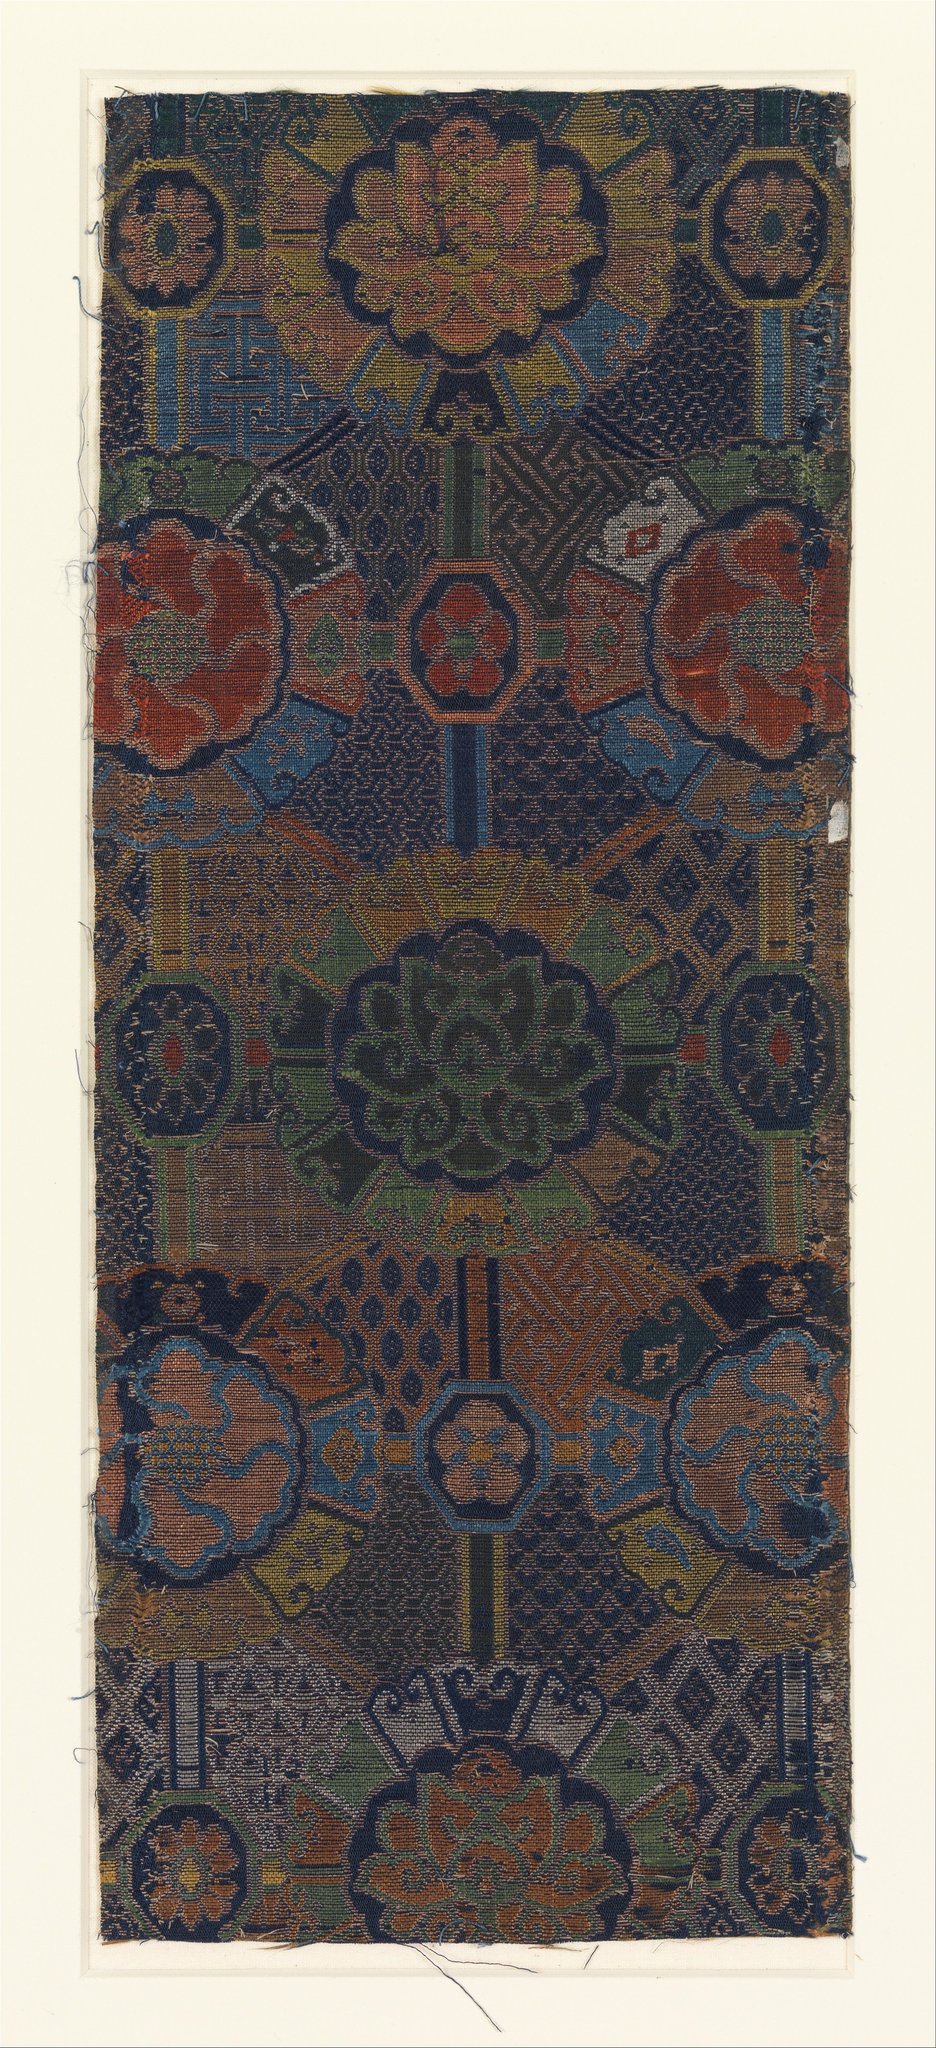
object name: sutra cover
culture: chinese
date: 1601-1700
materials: metal thread, silk